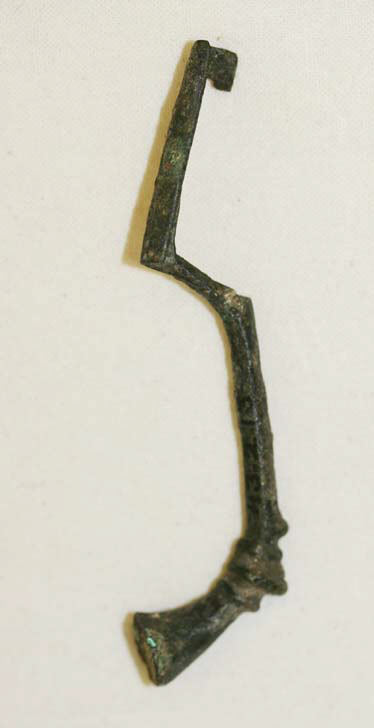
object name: pin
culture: european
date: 400-301 BCE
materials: bronze